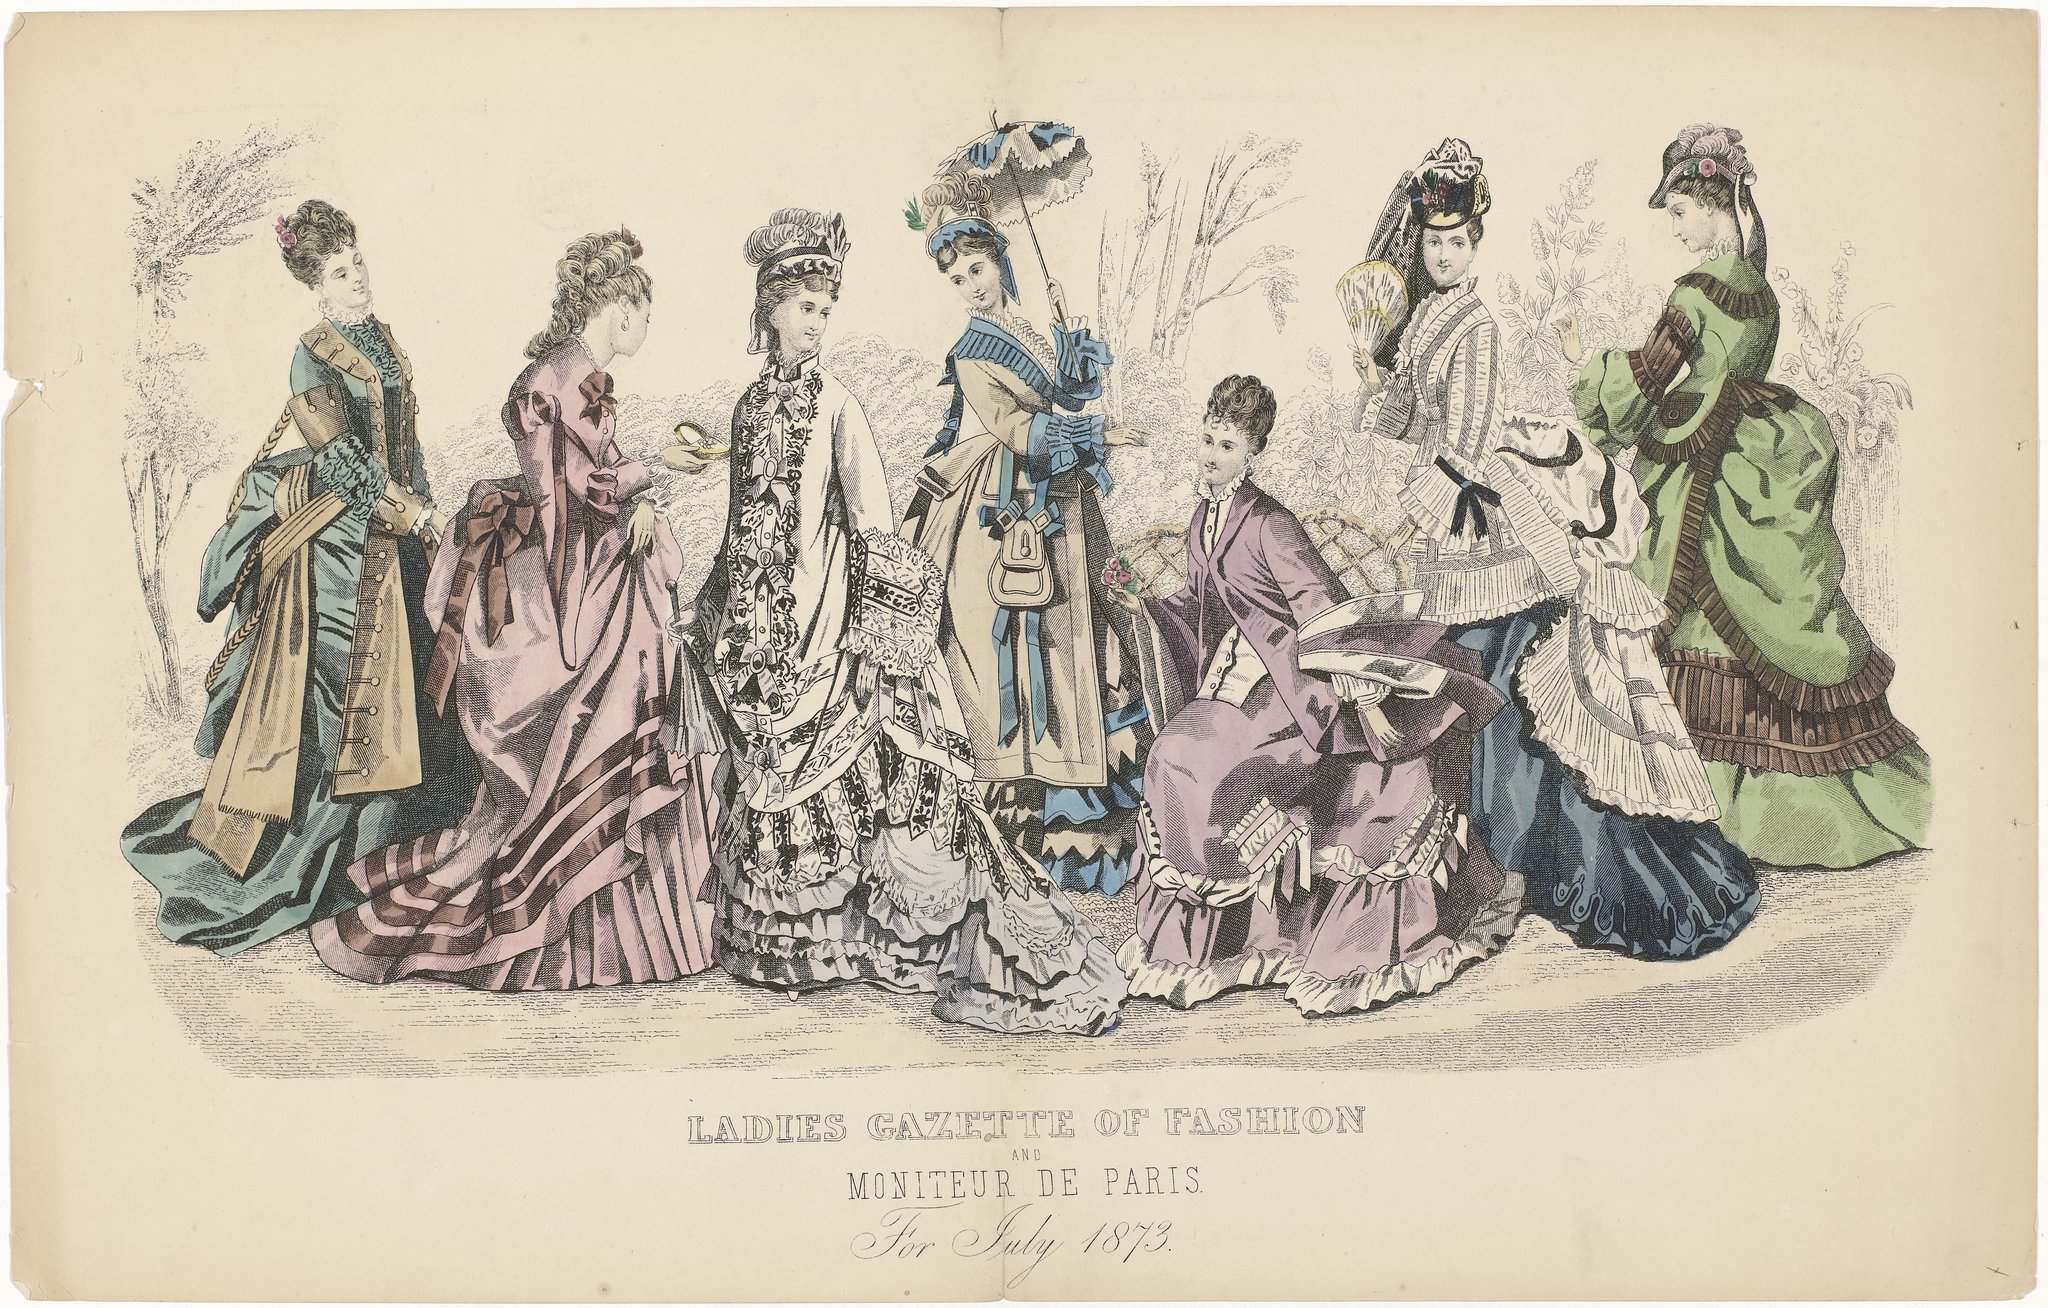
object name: fashion print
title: Ladies Gazette of Fashion and Moniteur de Paris for July 1873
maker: Anonymous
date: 1873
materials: paper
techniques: engraving, hand coloring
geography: london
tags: veil (+ women's clothes), bag (handbag) (+ women's clothes), fashion plates, head-gear: hat (+ women's clothes), skirt (+ women's clothes), fan (+ women's clothes), sleeves (+ women's clothes), parasol, sunshade (+ women's clothes), display of jewels, etc.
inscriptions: title: ‘LADIES GAZETTE OF FASHION / AND / MONITEUR DE PARIS / For July 1873.’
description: Zeven vrouwen in een park gekleed volgens de mode van juli 1873. Prent uit het Engelse modetijdschrift 'The Ladies Gazette of Fashion' (1842-1894).